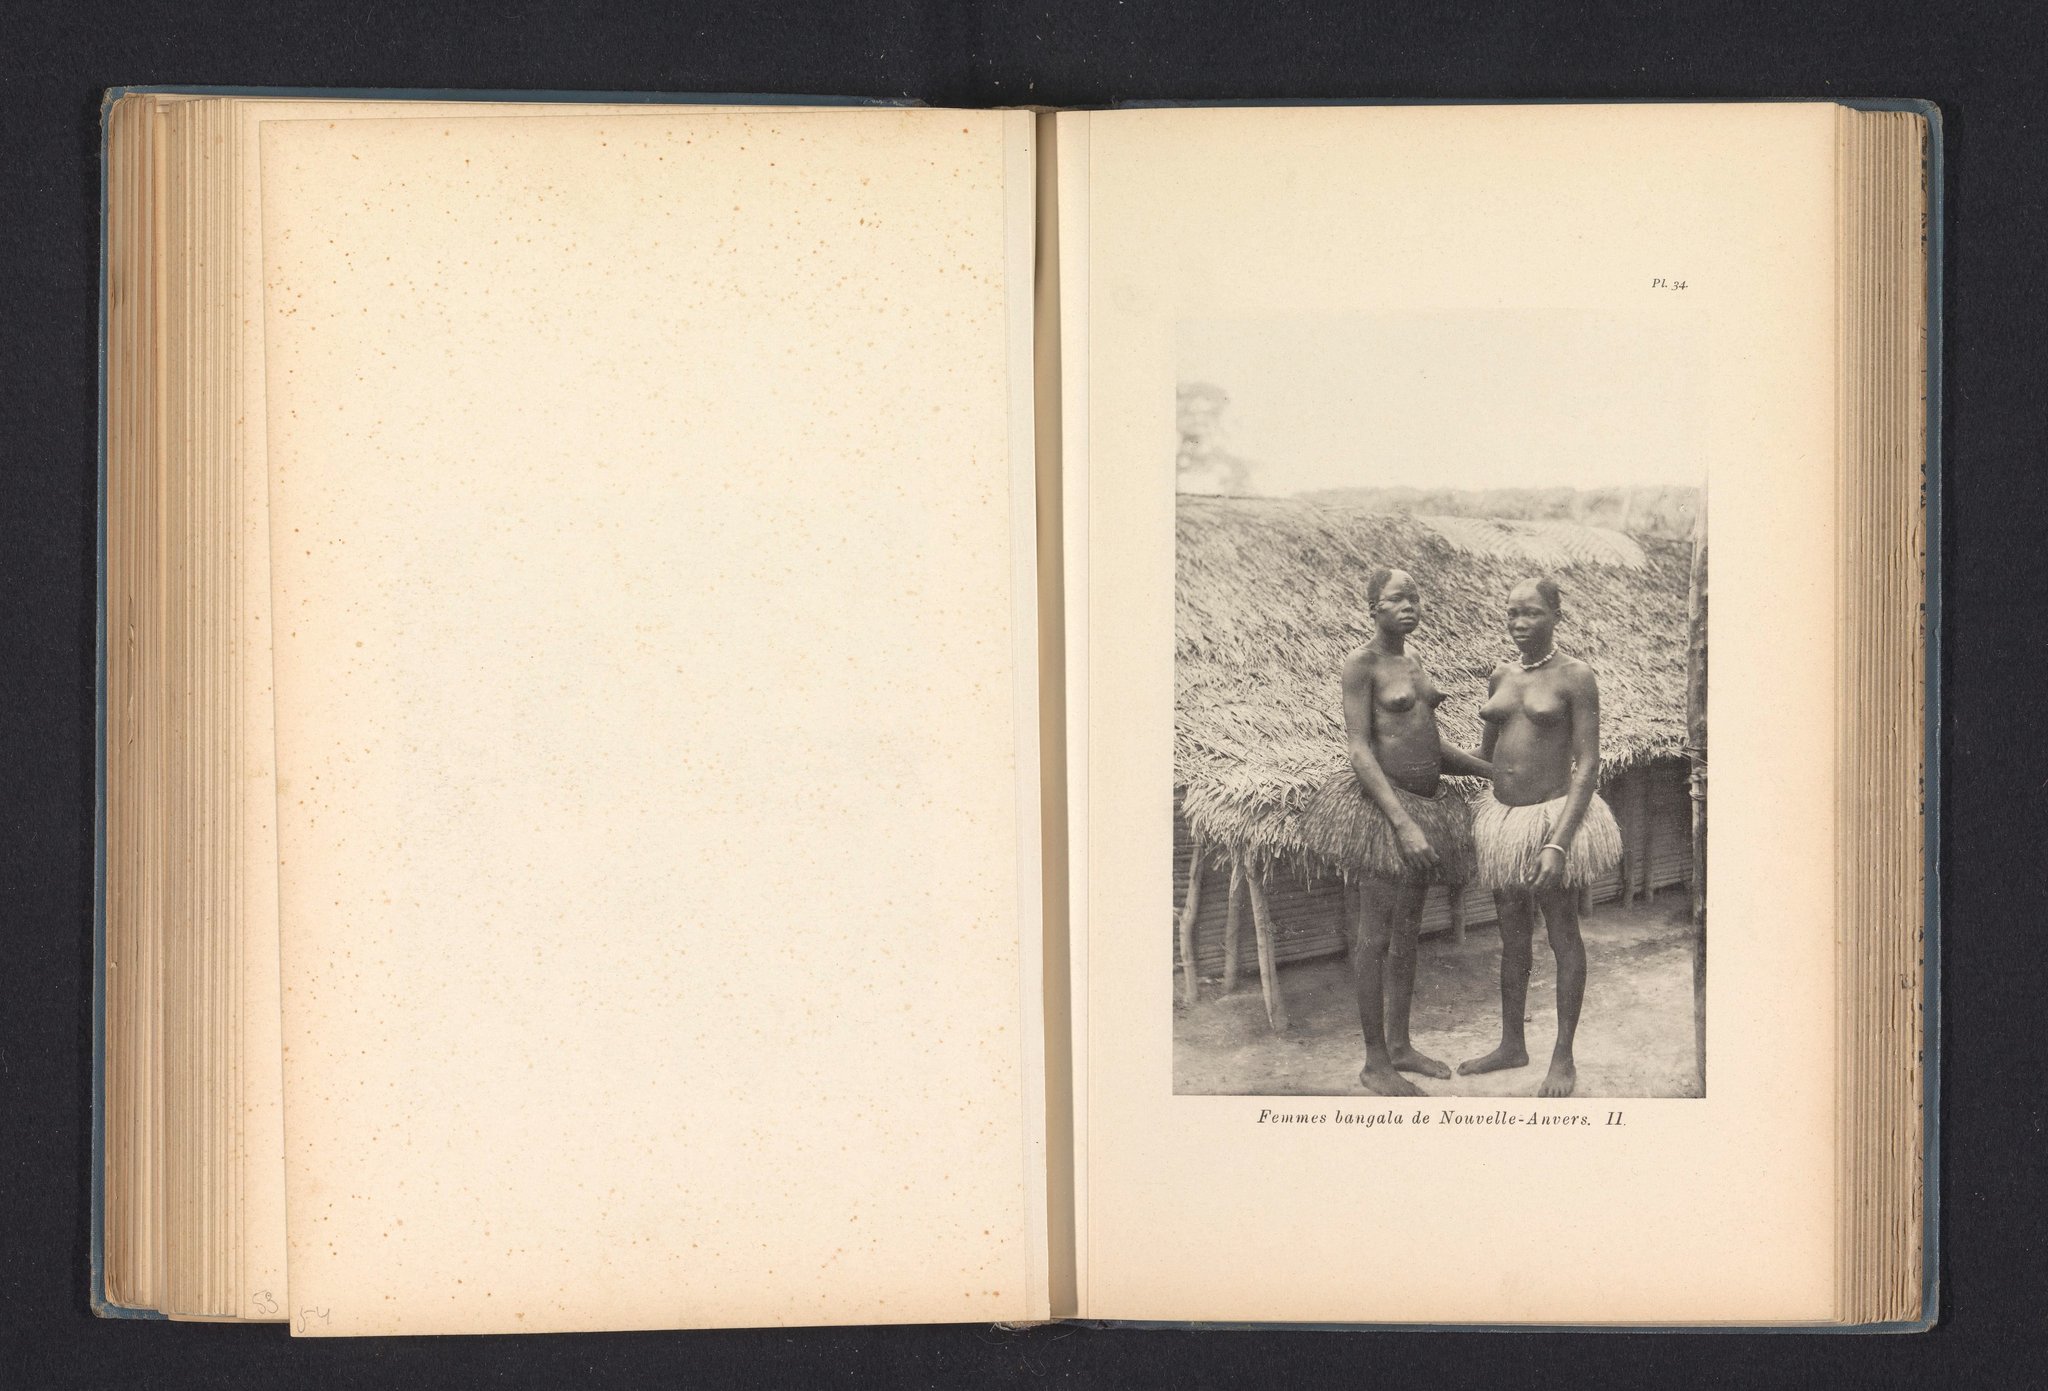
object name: photomechanical print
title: Portret van twee vrouwen van de Bangala te Nieuw-Antwerpen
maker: franz thonner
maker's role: botanicus, ontdekkingsreiziger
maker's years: 1863-1928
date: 1896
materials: paper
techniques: photograph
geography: nieuw-antwerpen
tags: adult woman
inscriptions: number: ‘Pl. 34.’